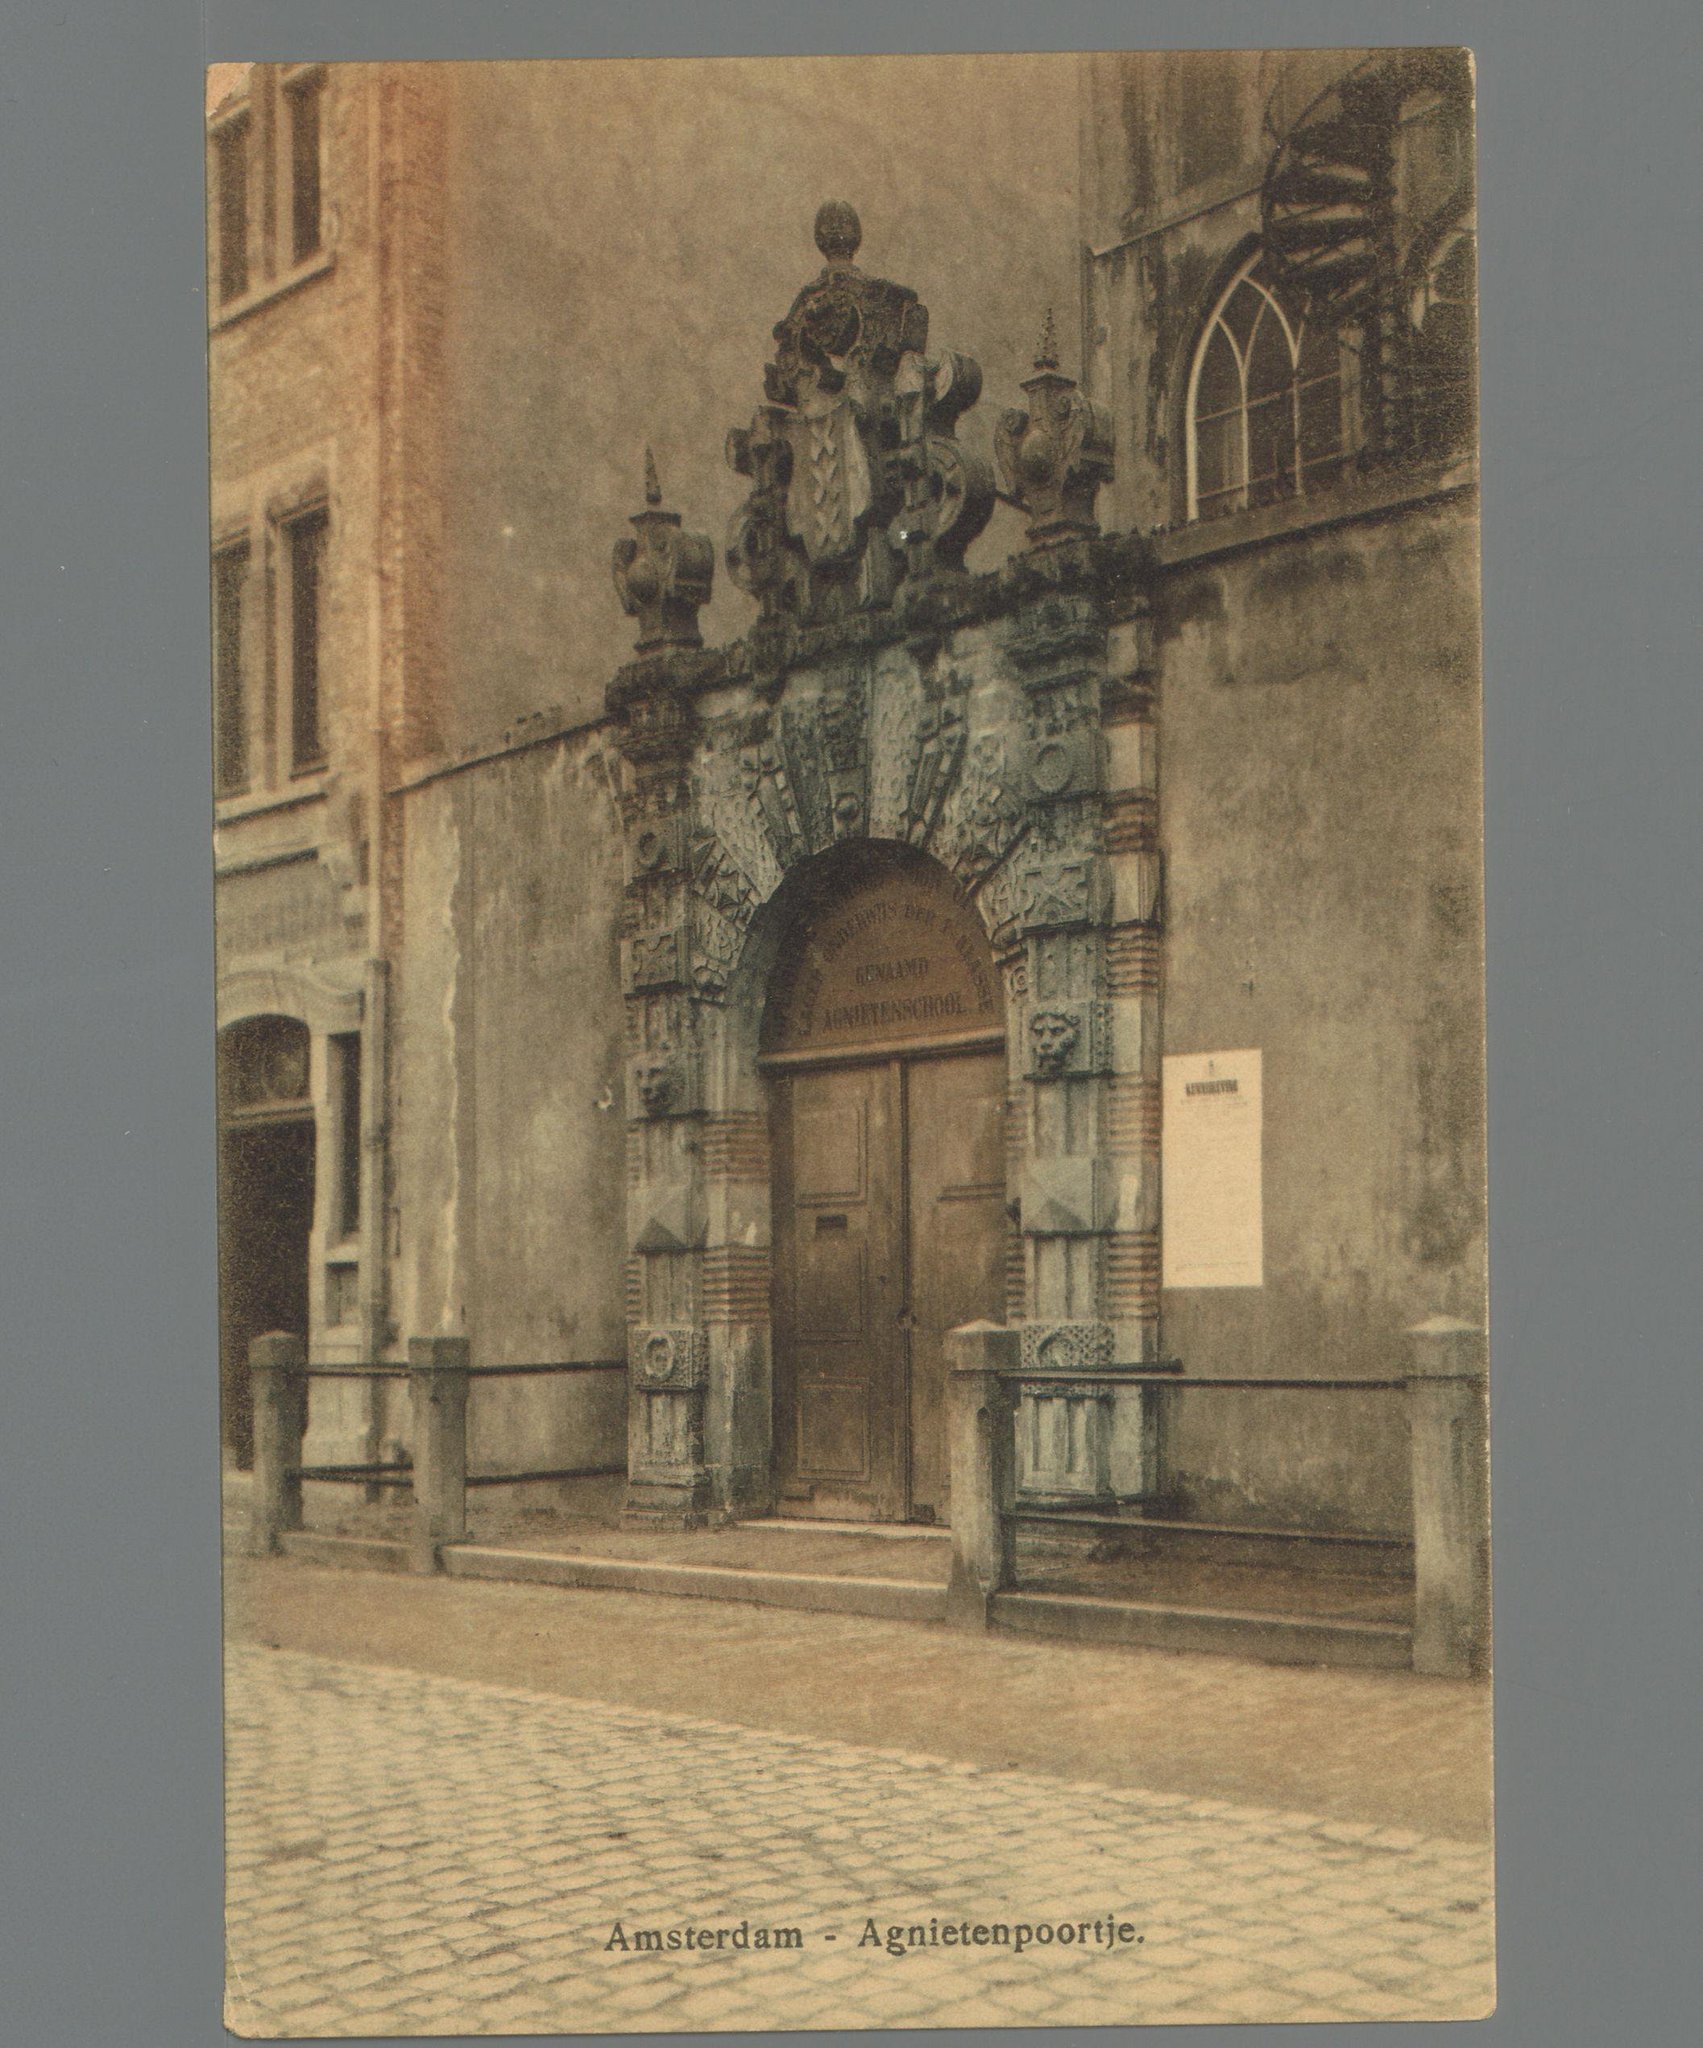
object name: ansichtkaart, prentbriefkaart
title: Amsterdam - Agnietenpoortje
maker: Anonymous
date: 1910-1912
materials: cardboard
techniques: collotype process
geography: amsterdam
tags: coat of arms (as symbol of the state, etc.), gate, entrance